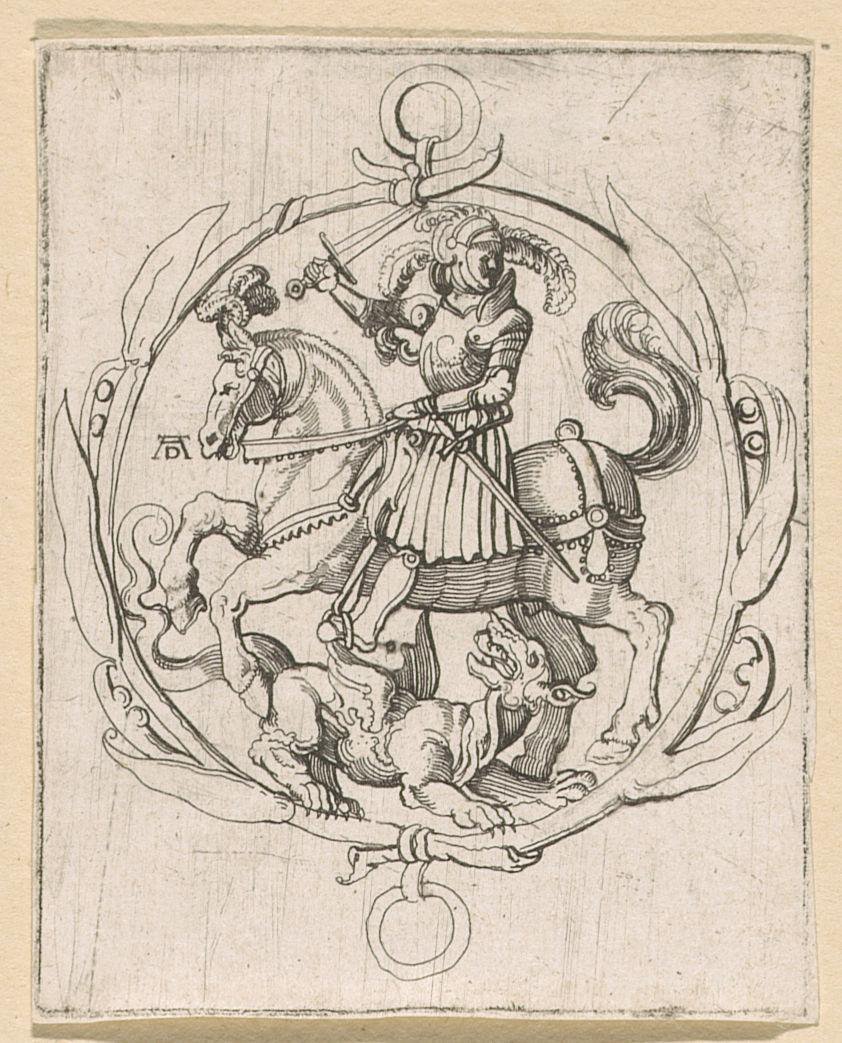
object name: print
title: Joris en de draak in omlijsting van planten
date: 1600-1699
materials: paper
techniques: etching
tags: dragon, the warrior martyr george (georgius); possible attributes: banner (red cross on white field), (red) cross, dragon, (white) horse, broken lance, shield (with cross), sword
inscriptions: monogram (false): ‘AD’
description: Mogelijk naar ontwerp van Albrecht Dürers houtsnede van de Heilige Joris uit de Salus Animae reeks.